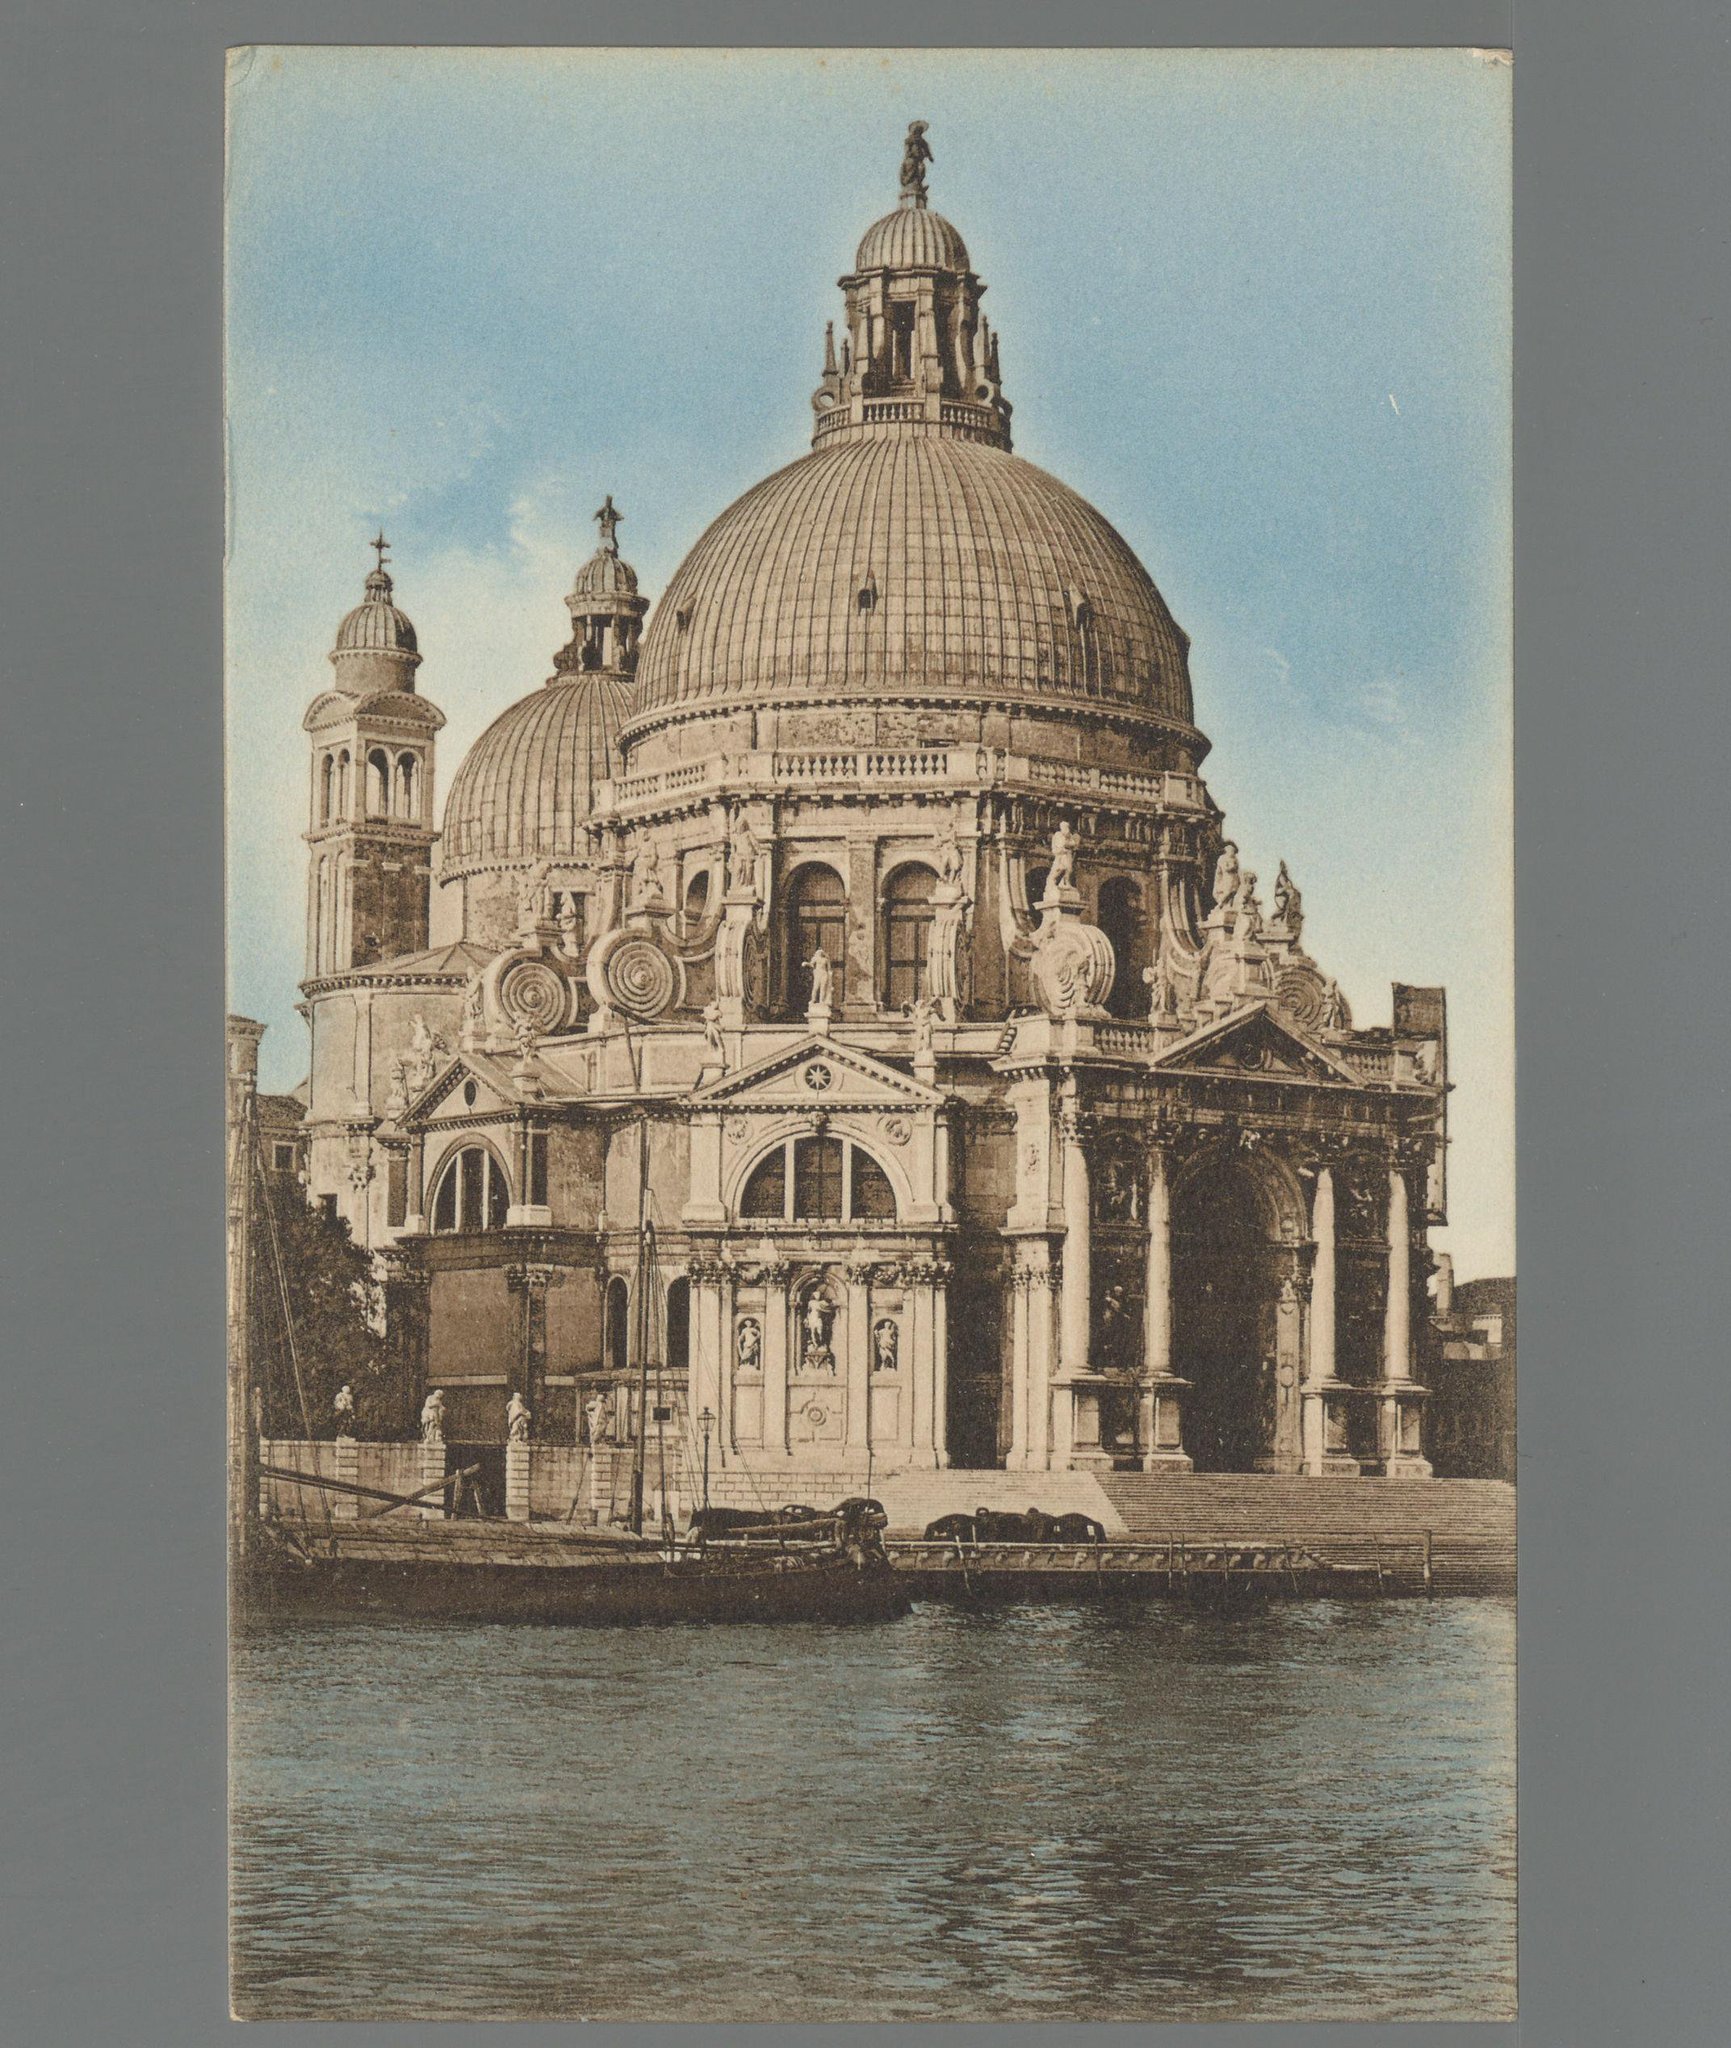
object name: photomechanical print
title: Venezia. Chiesa di S. Maria della Salute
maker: Anonymous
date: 1906-1920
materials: cardboard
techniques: photograph, lithograph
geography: venice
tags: canal, church (exterior)